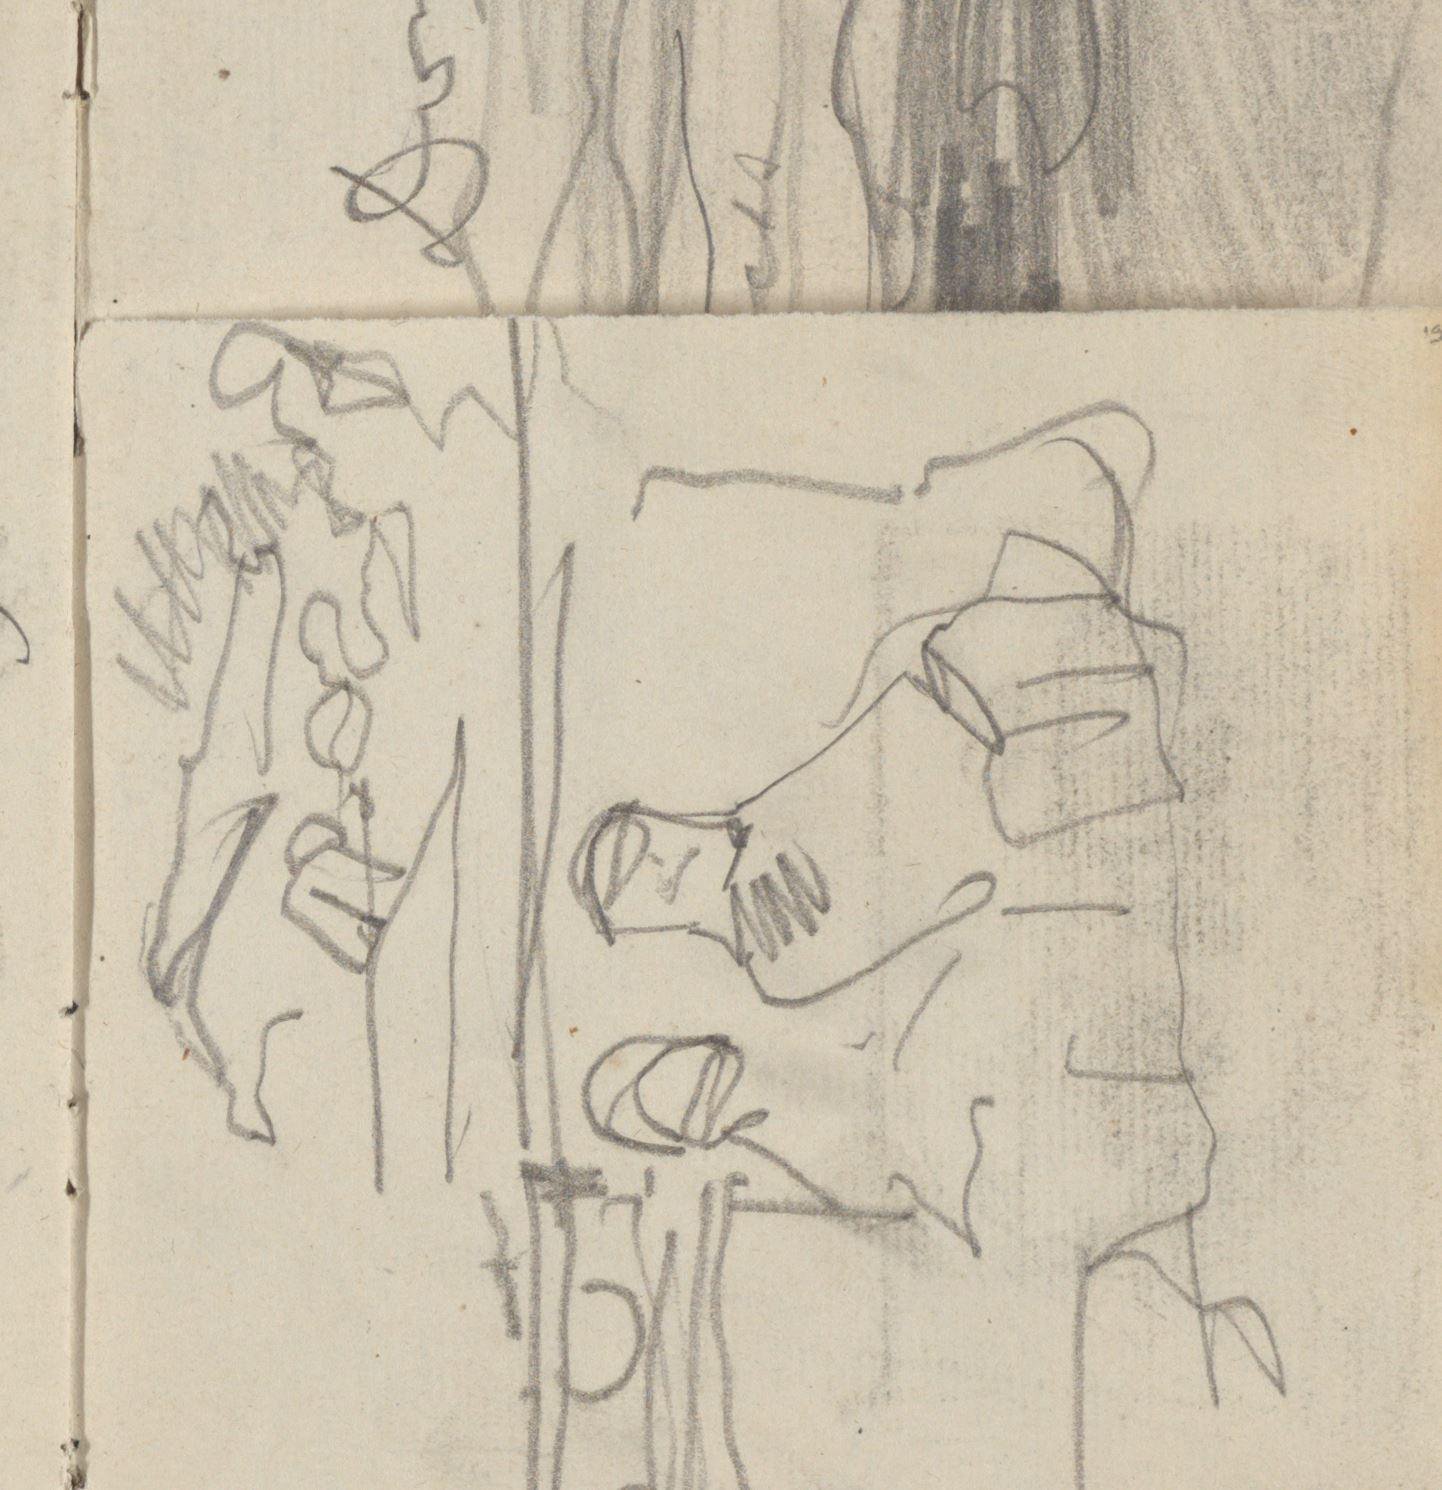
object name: sketchbook leaf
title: Zittende figuren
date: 1881-1883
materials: paper, pencil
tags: sitting figure, sitting figure - aa - female human figure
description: Pagina 19 uit een schetsboek met 29 bladen.